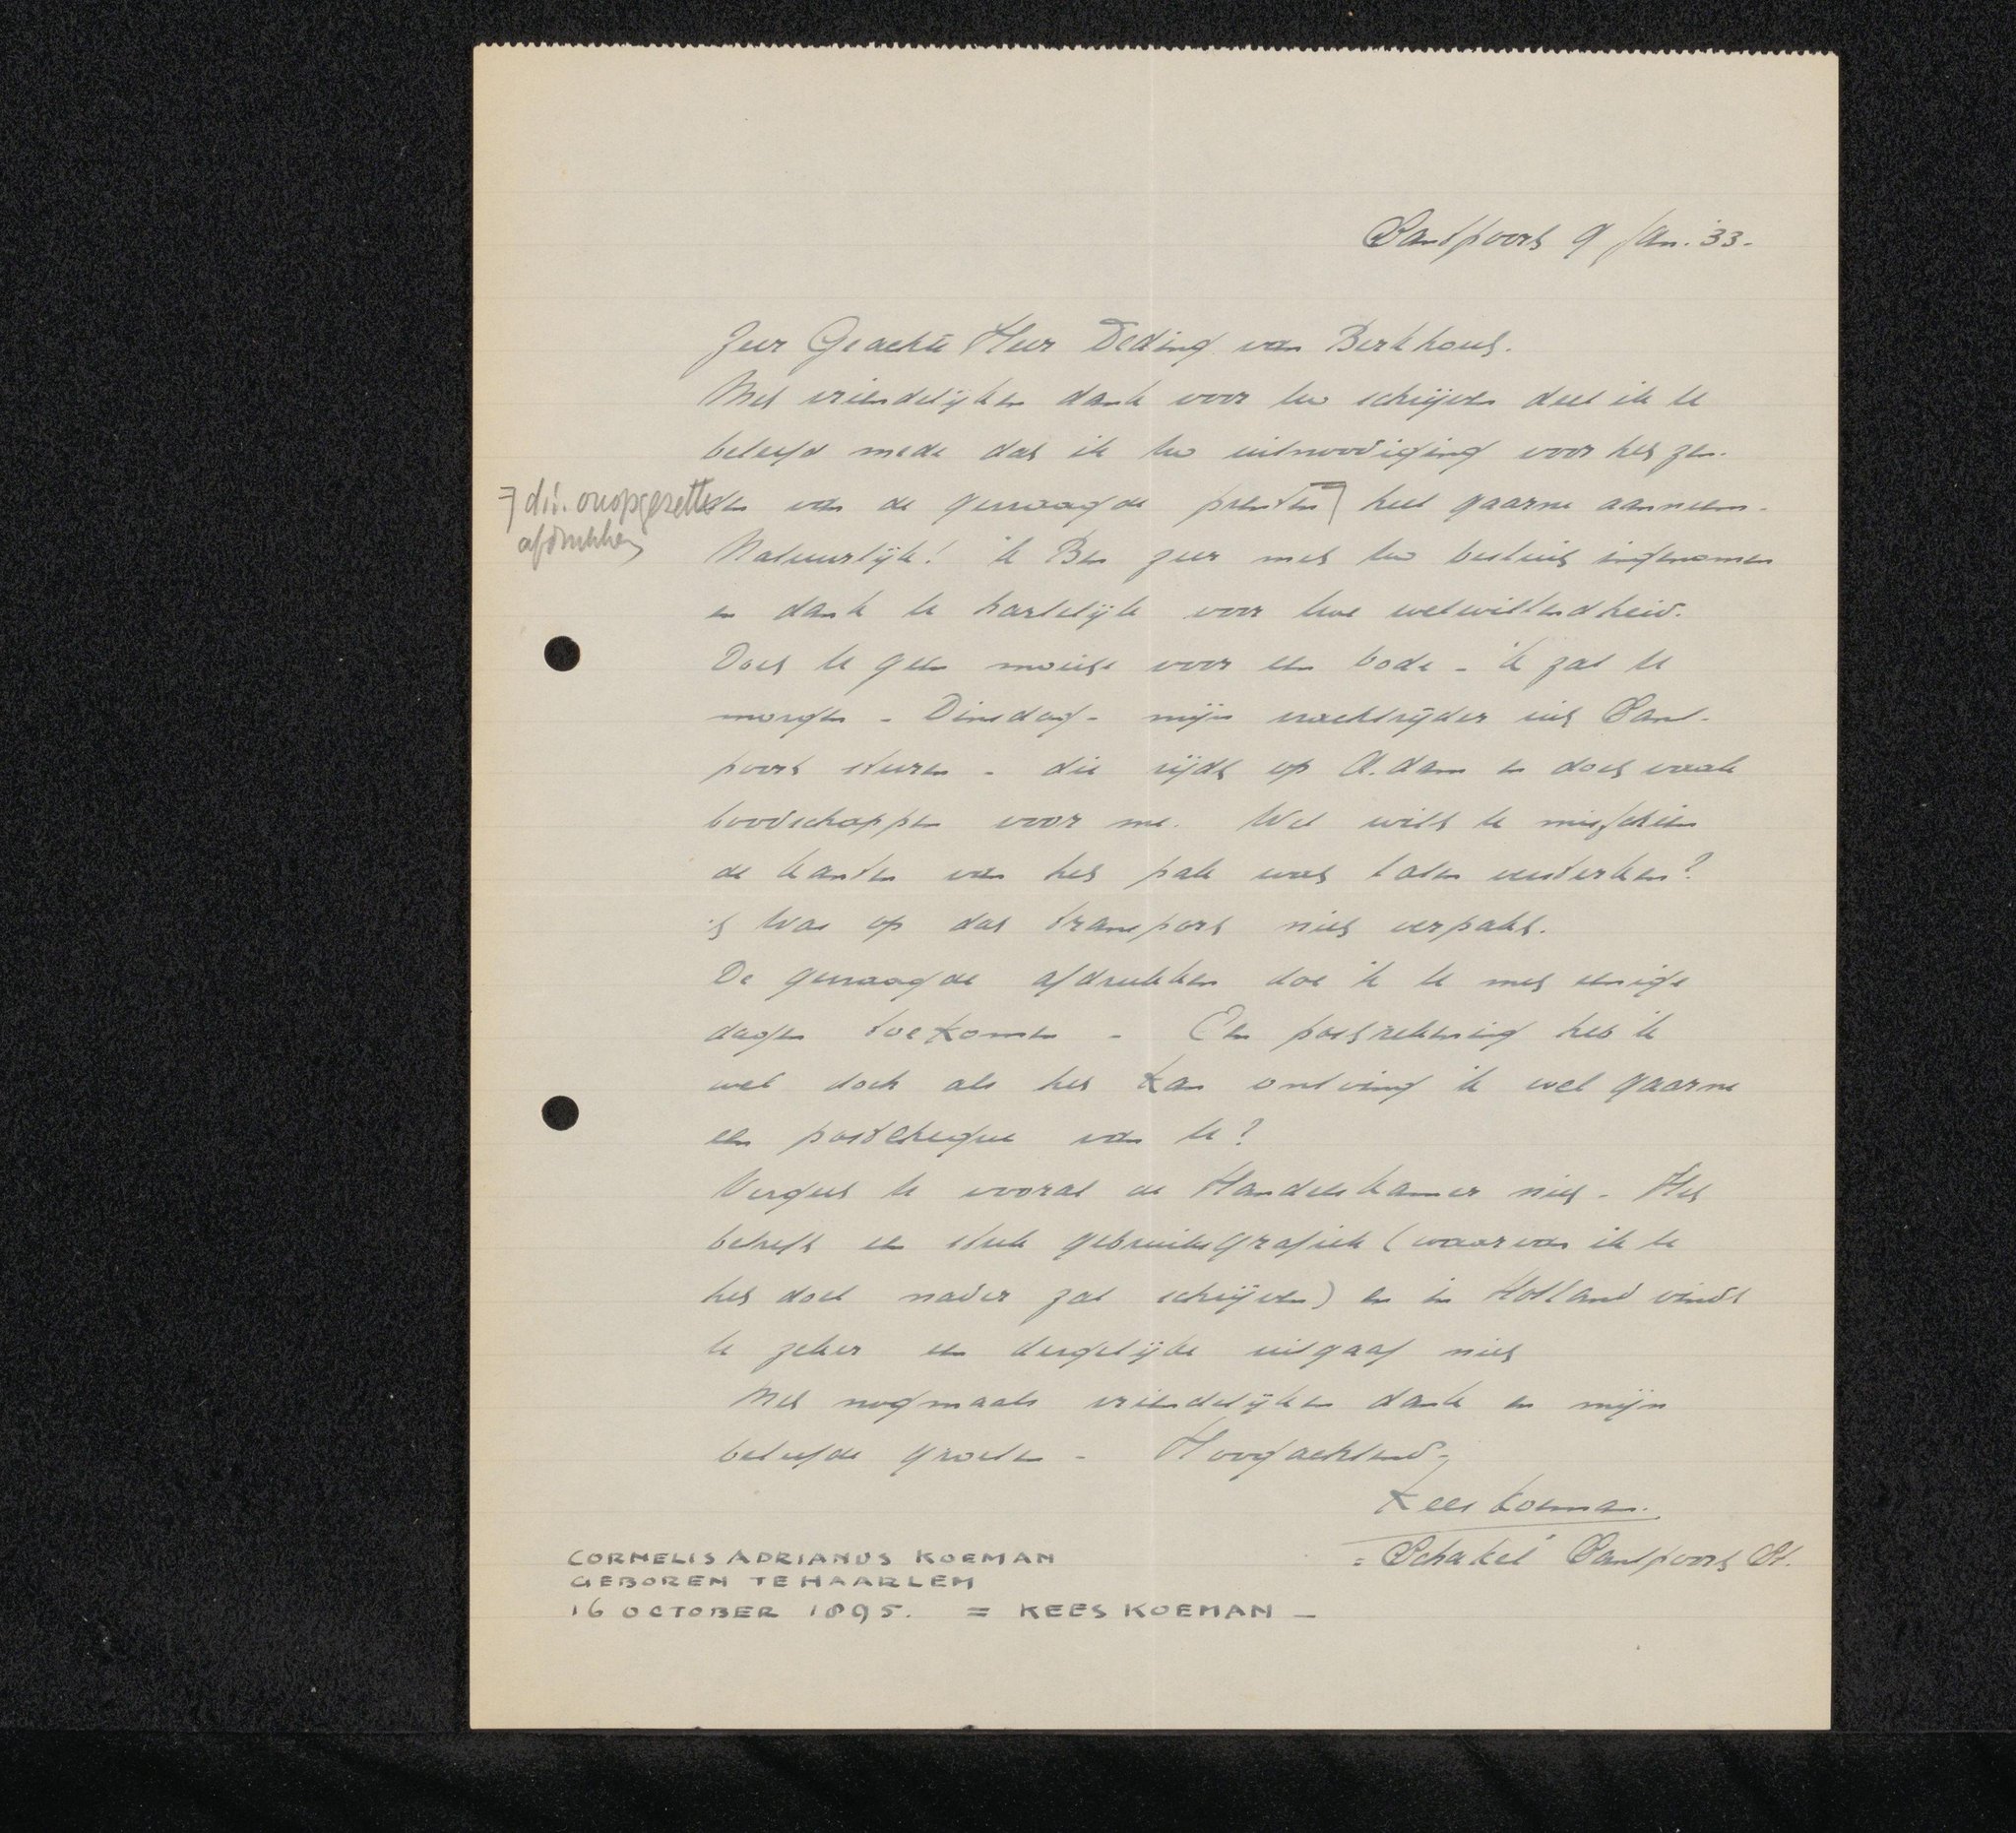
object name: letter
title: Brief aan jonkheer Hendrik Teding van Berkhout (1879-1969)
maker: kees koeman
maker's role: print maker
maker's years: 1895-1954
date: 1933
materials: ink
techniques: pen, writing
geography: santpoort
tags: haarlem, amsterdam, jonkheer hendrik teding van berkhout (1879-1969), the graphic arts